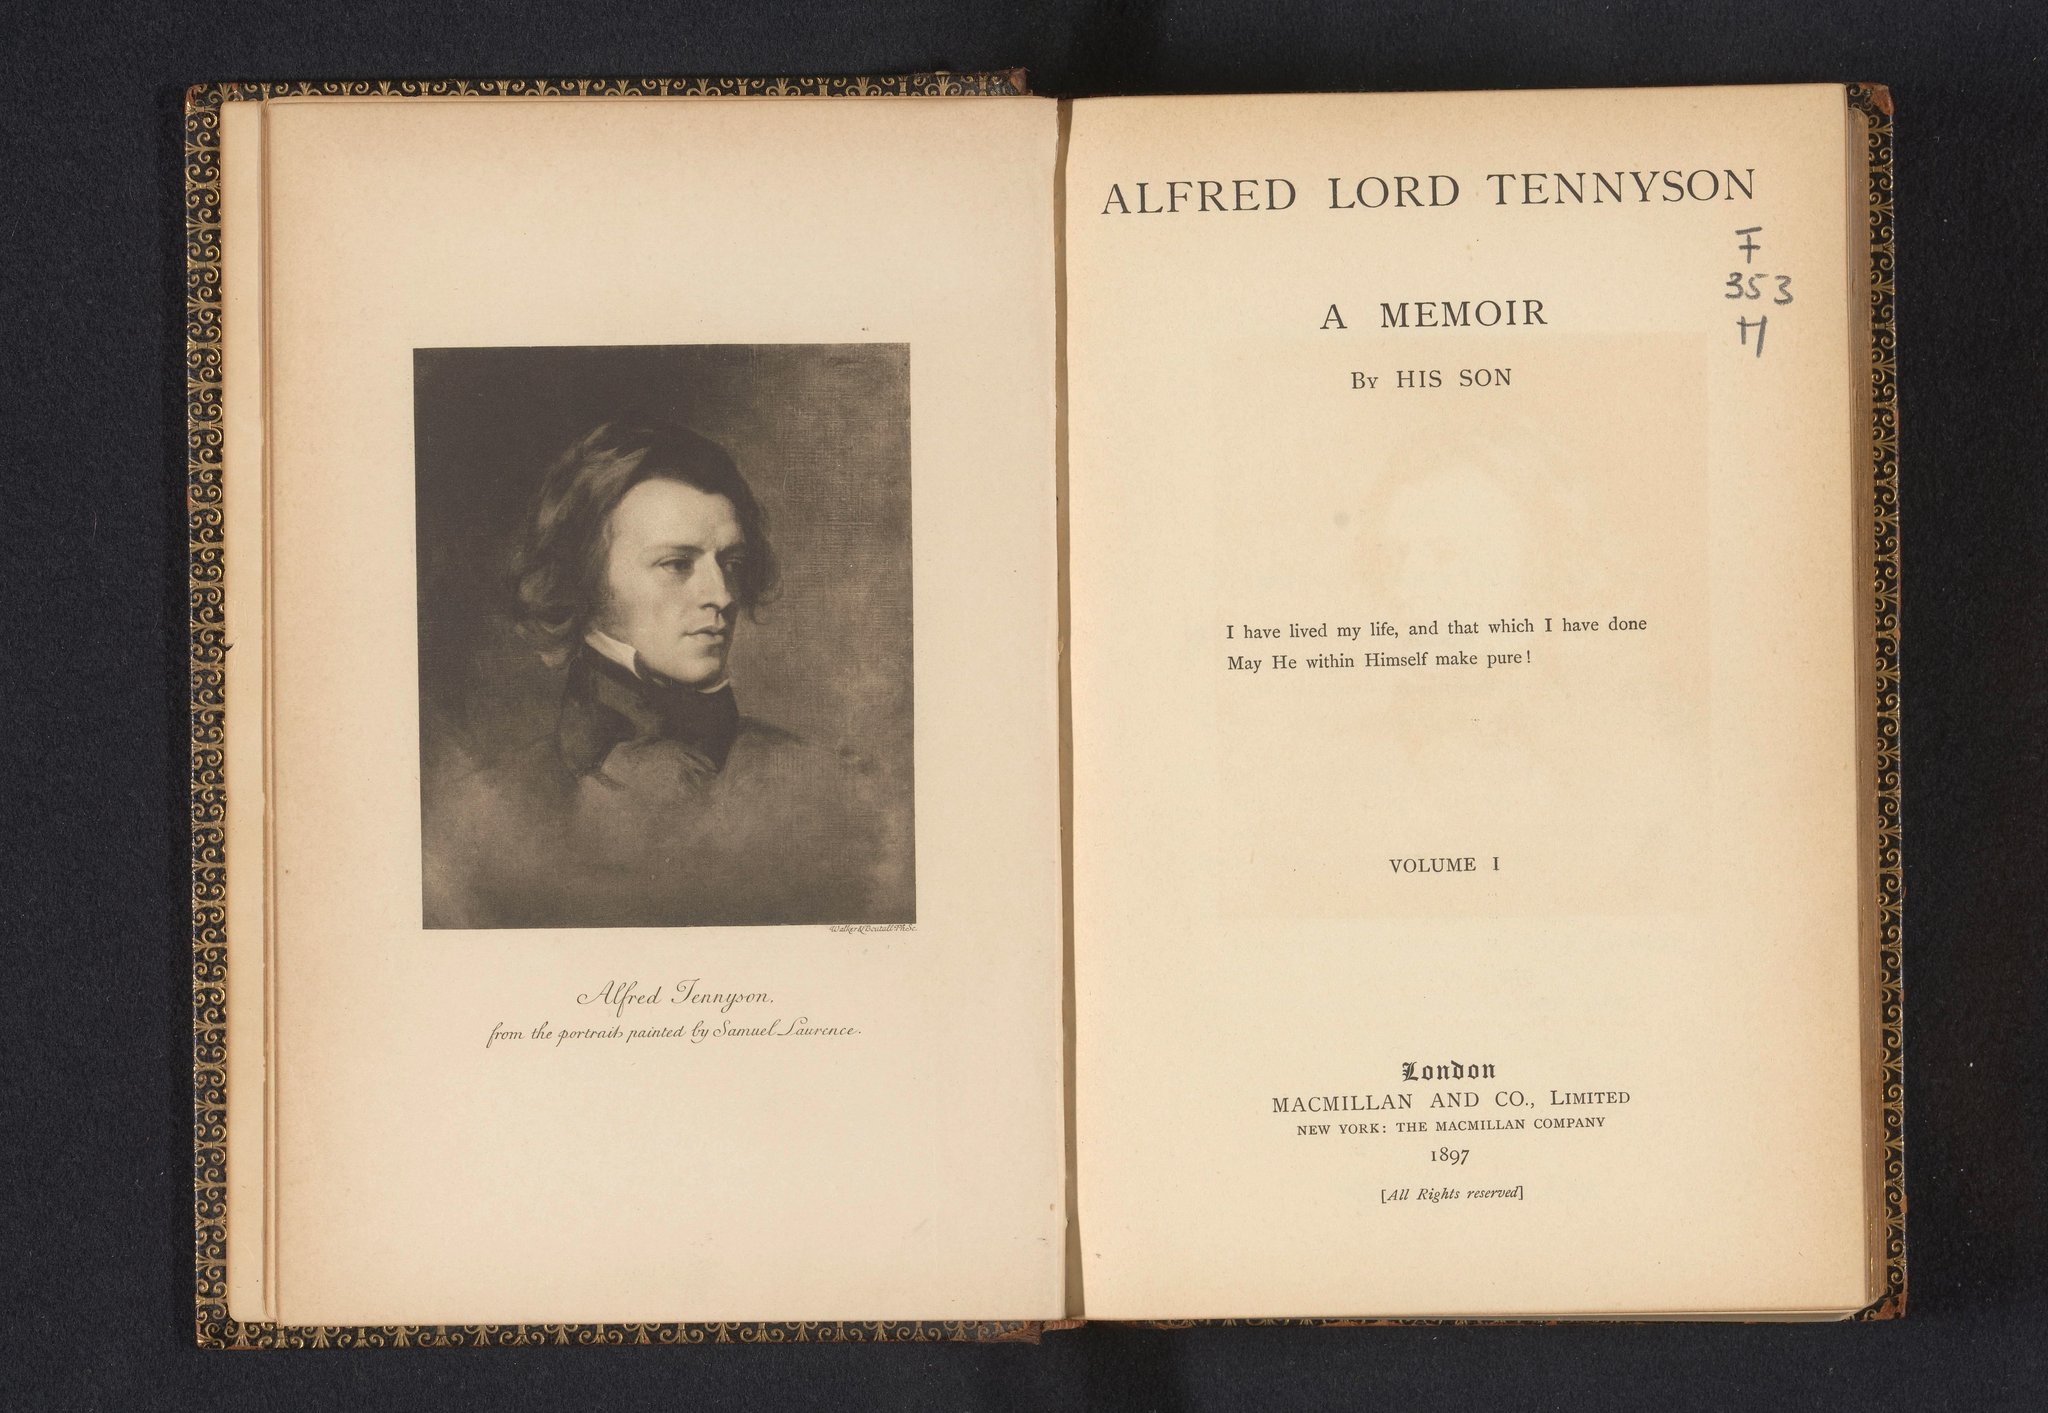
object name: page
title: Alfred Tennyson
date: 1887-1897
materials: paper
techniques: photoaquatint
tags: alfred tennyson, portrait of a writer